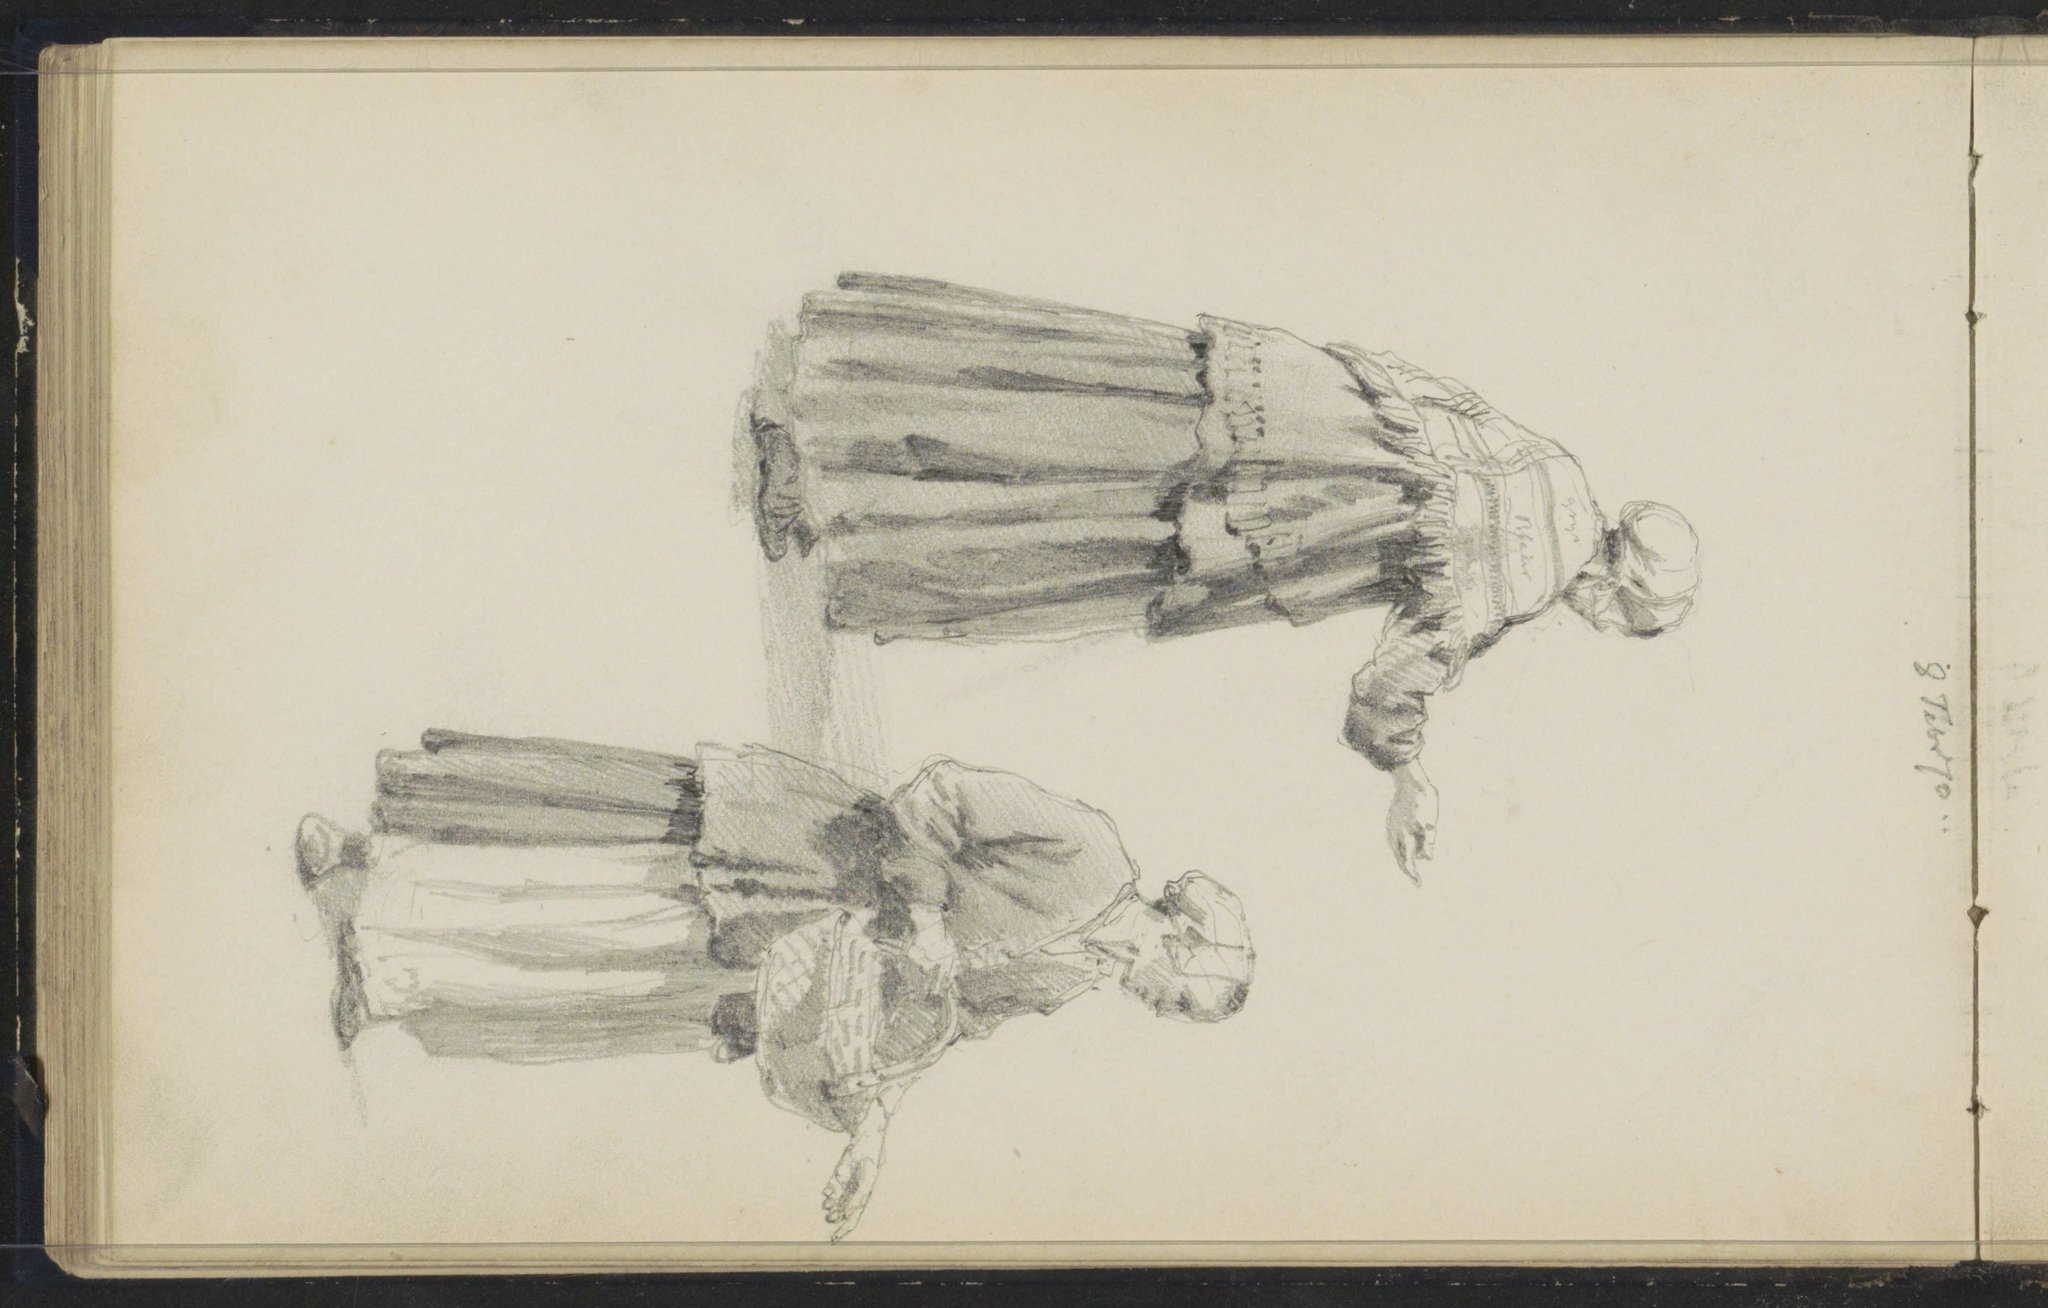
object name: sketchbook leaf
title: Twee vrouwen met een uitgestrekte arm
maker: cornelis springer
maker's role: draughtsman, painter, print maker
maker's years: 1817-1891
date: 1870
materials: paper, pencil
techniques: stumping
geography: netherlands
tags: adult woman, arm stretched forward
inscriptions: date: ‘8 Febr 70’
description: Twee vrouwen met een uitgestrekte arm. De bovenste vrouw draagt een omslagdoek. De onderste vrouw heeft een mand in haar hand. Blad 24 verso uit een schetsboek met 40 bladen, vervaardigd in Woerden en Gouda.